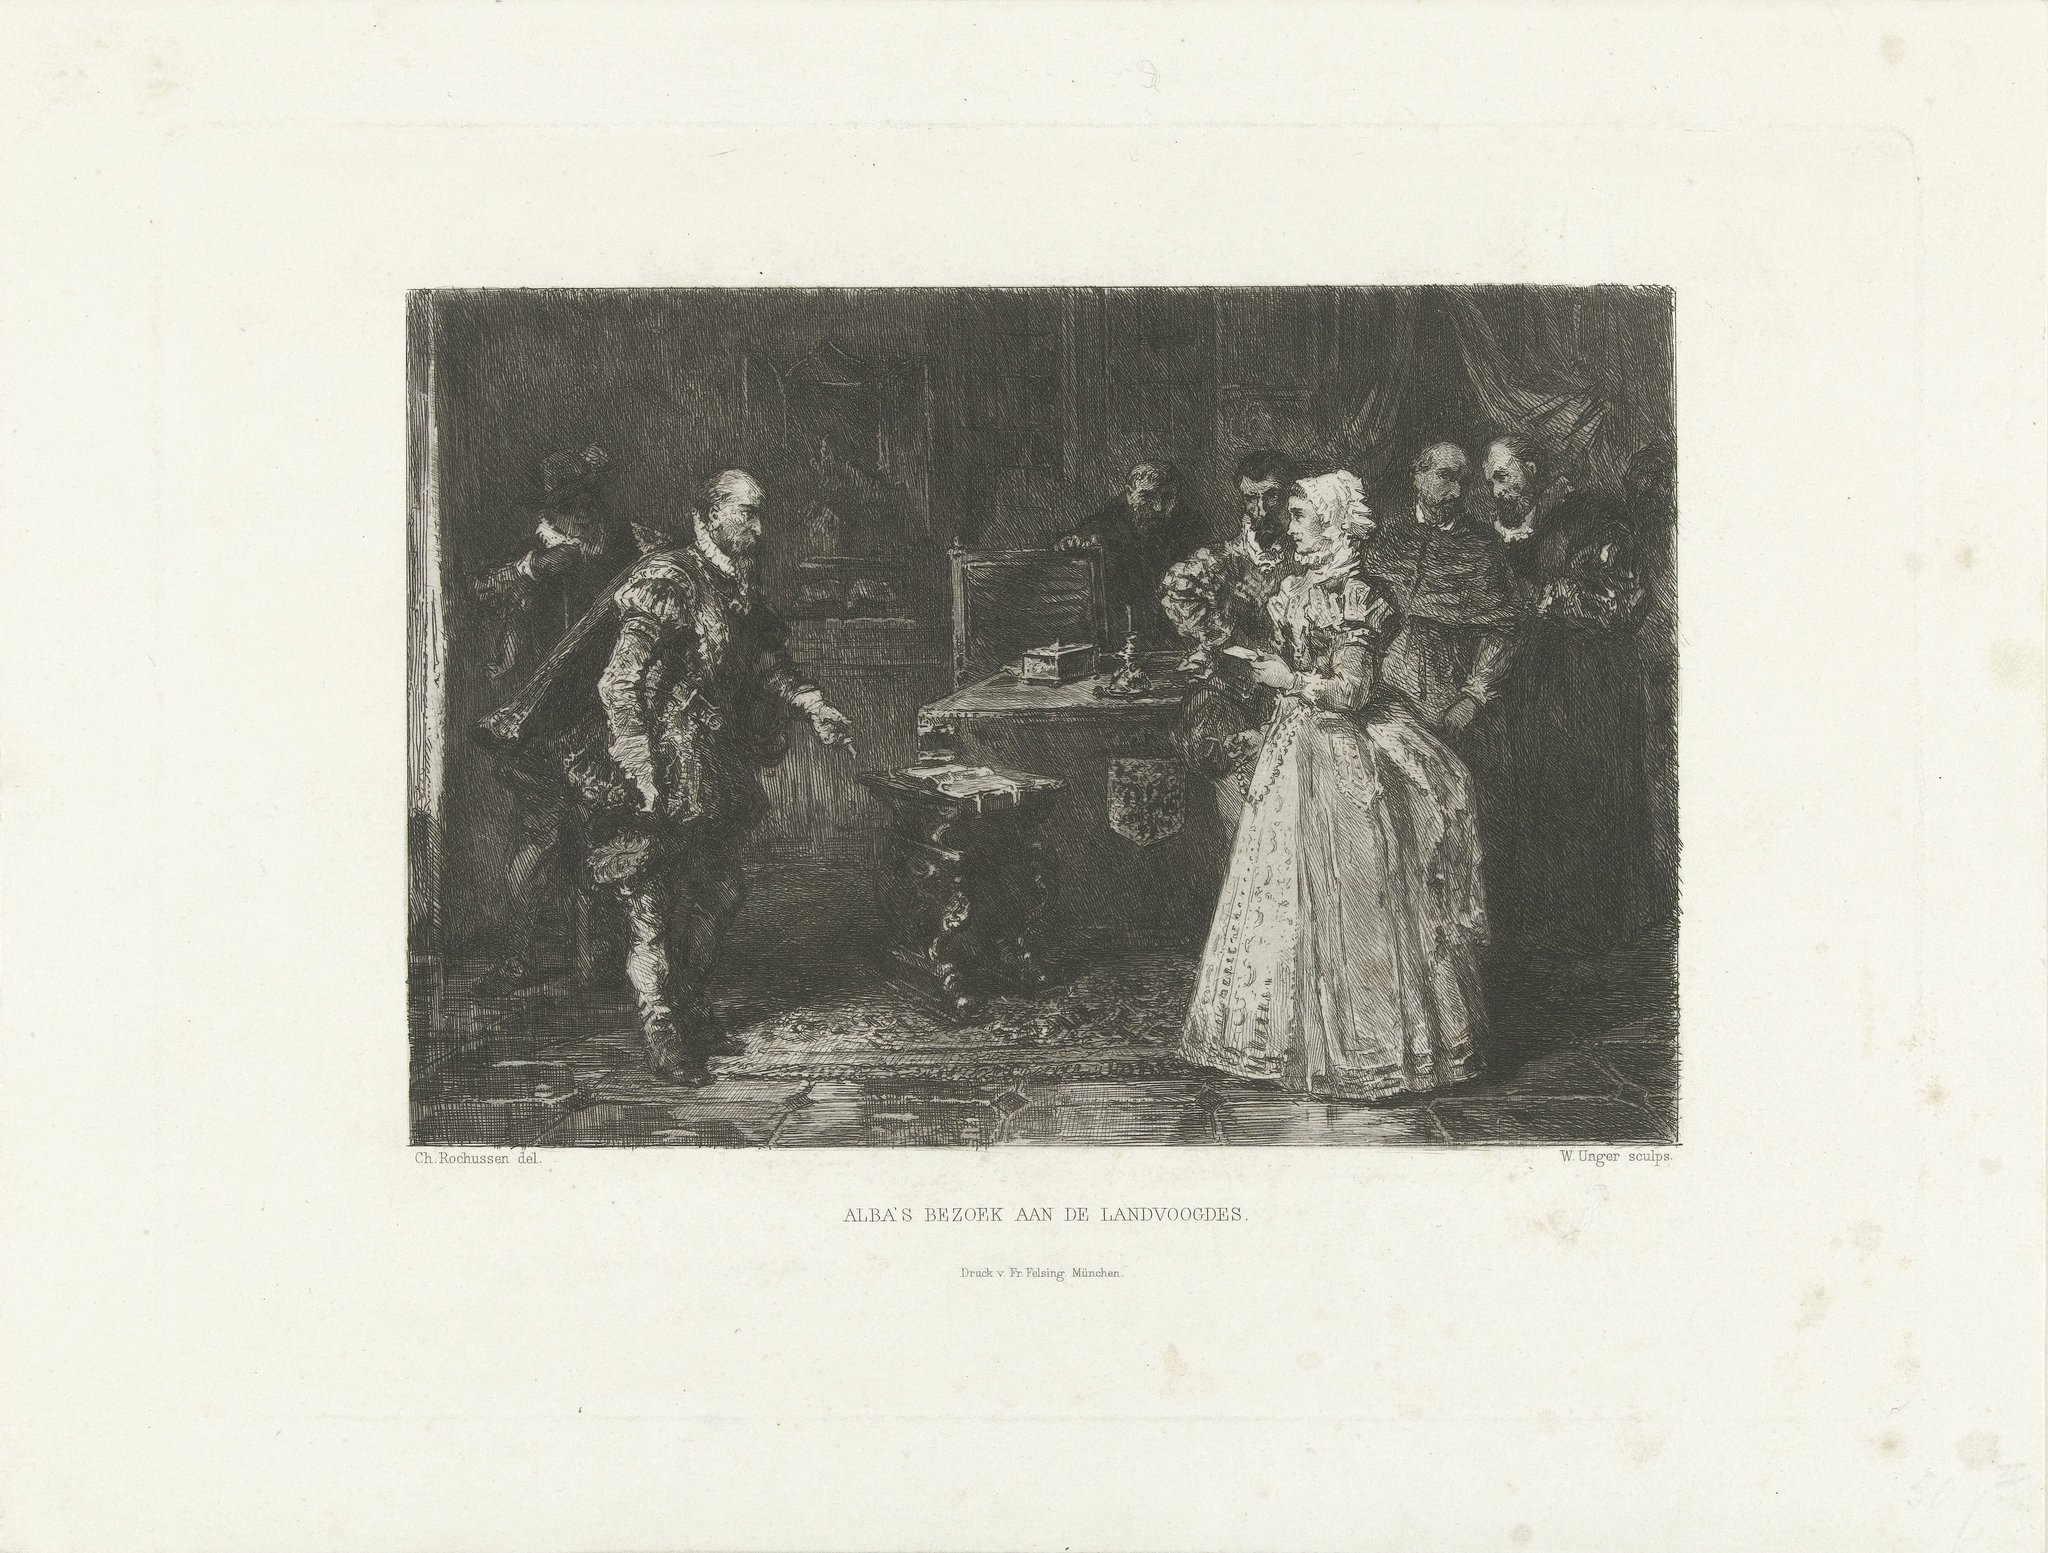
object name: print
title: Alva bezoekt de landvoogdes Margaretha van Parma, 1567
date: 1871-1873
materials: paper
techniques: etching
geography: germany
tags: fernando álvarez de toledo (3rd duke of alba), brussels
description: Gebruikt als illustratie in: In memoriam. Tafereelen uit Hollands tachtig-jarigen strijd. Met etsen van William Unger naar teekeningen van Ch. Rochussen en Herman ten Kate, Haarlem A.C. Kruseman 1873. Verschenen in 10 afleveringen met tekst en afbeelding, nr. 3. Niet in Frederik Muller; door het RPK toegevoegd nummer.